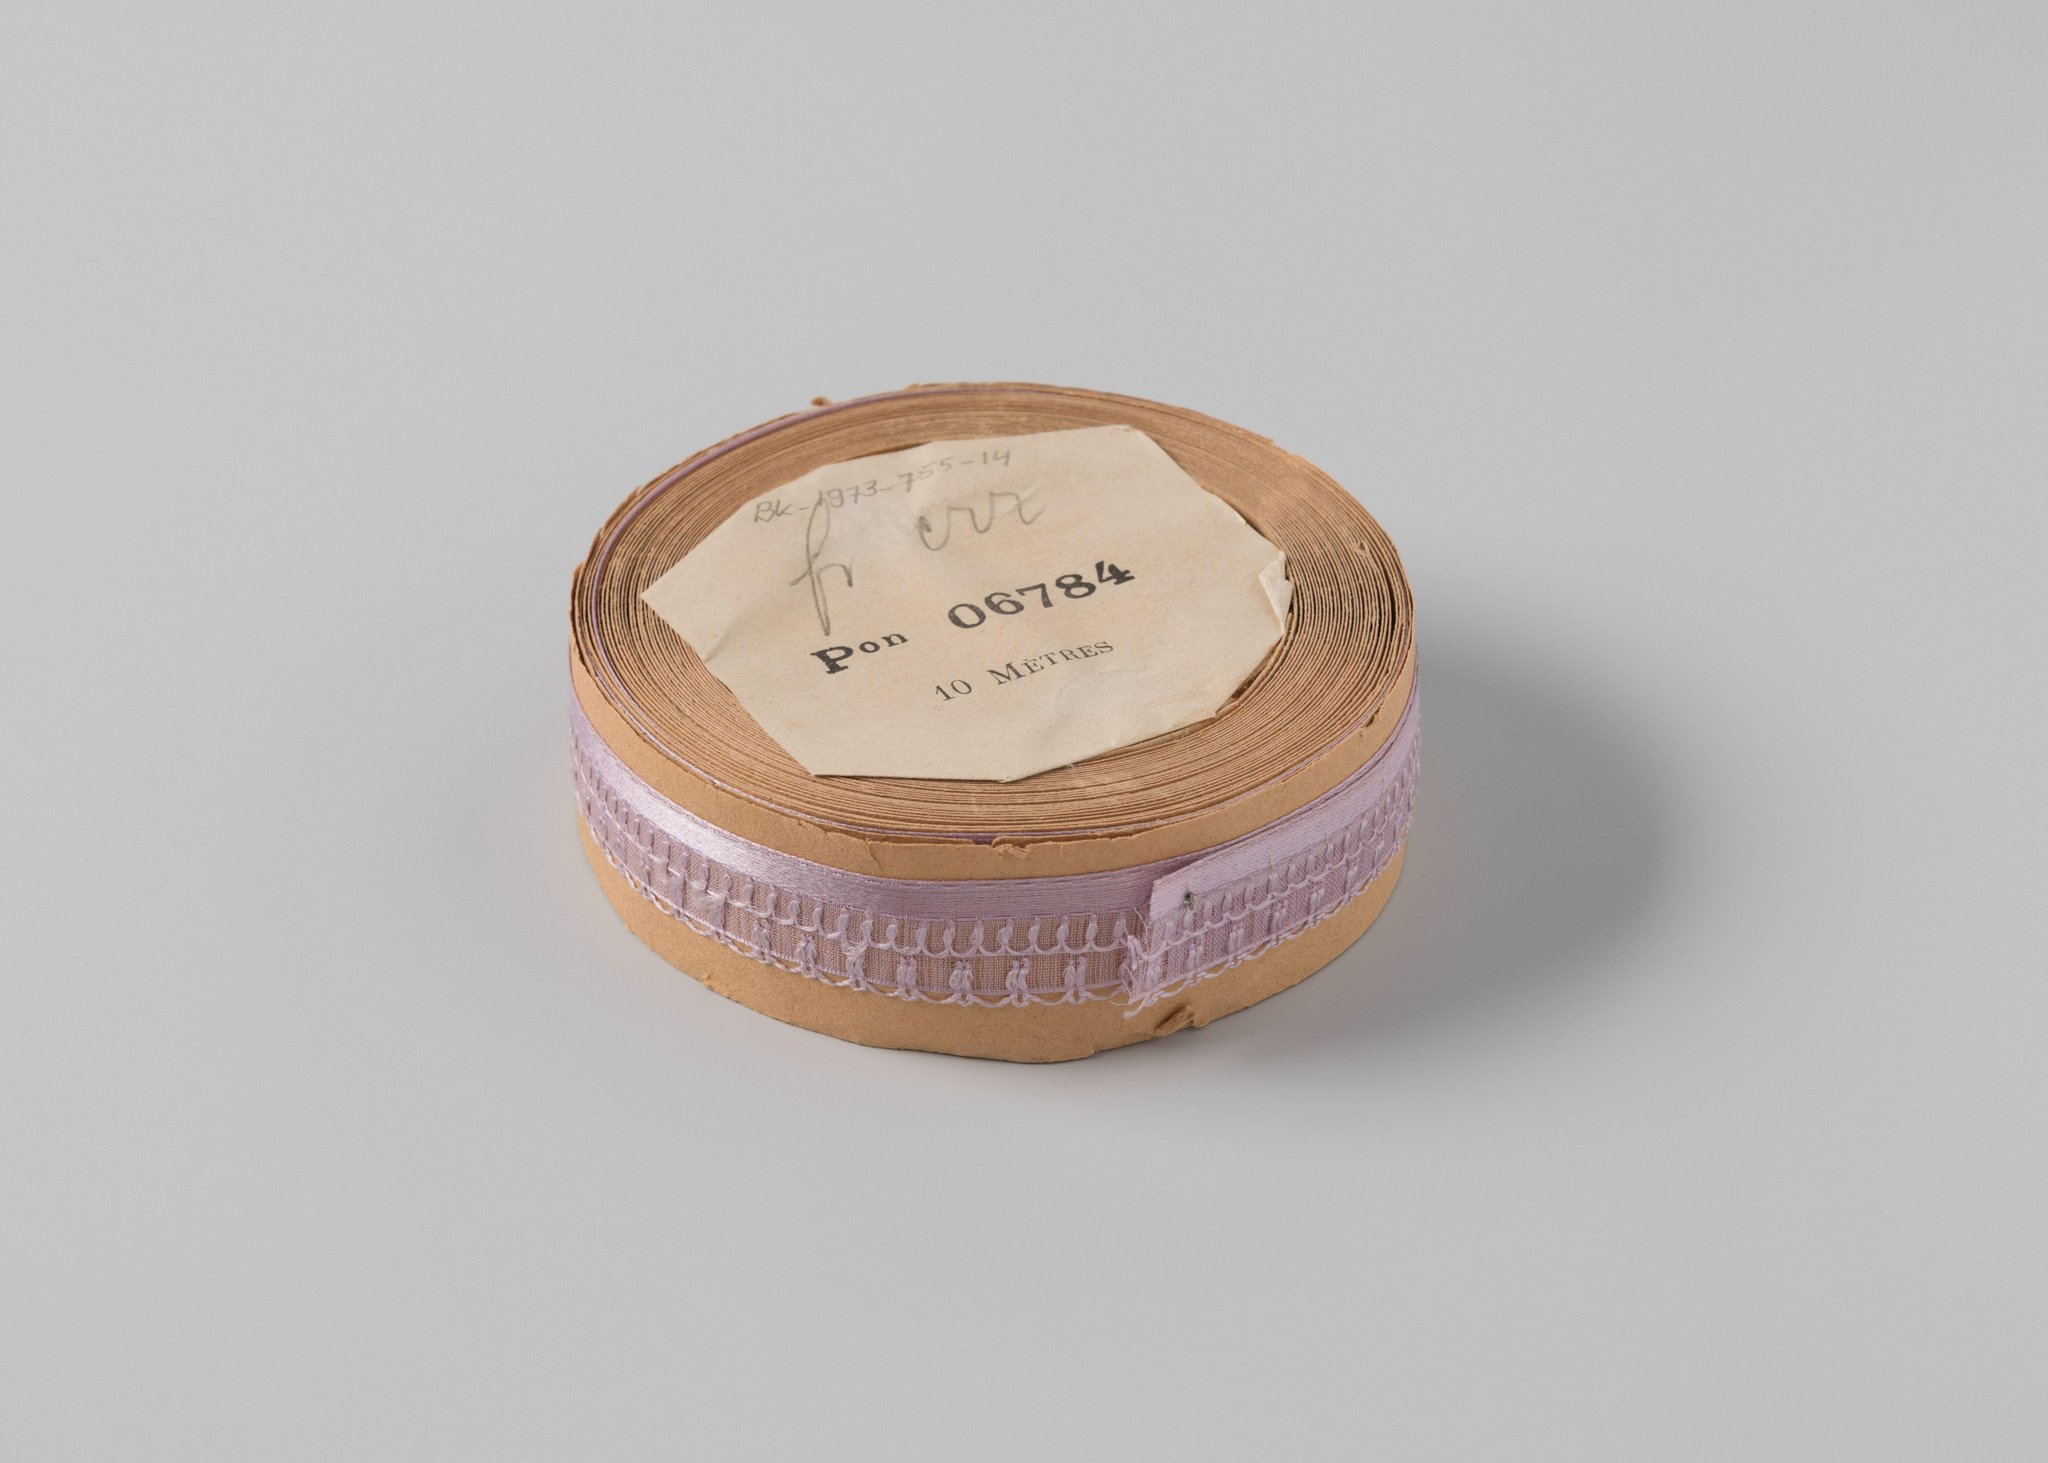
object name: braid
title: Lint op rol, lila gaaslint met twee rijen schulpen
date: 1890-1935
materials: cardboard, paper, textile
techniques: weave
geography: nijmegen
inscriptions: number: ‘Pon 06784’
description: Lint op rol, lila gaaslint met twee rijen schulpen.